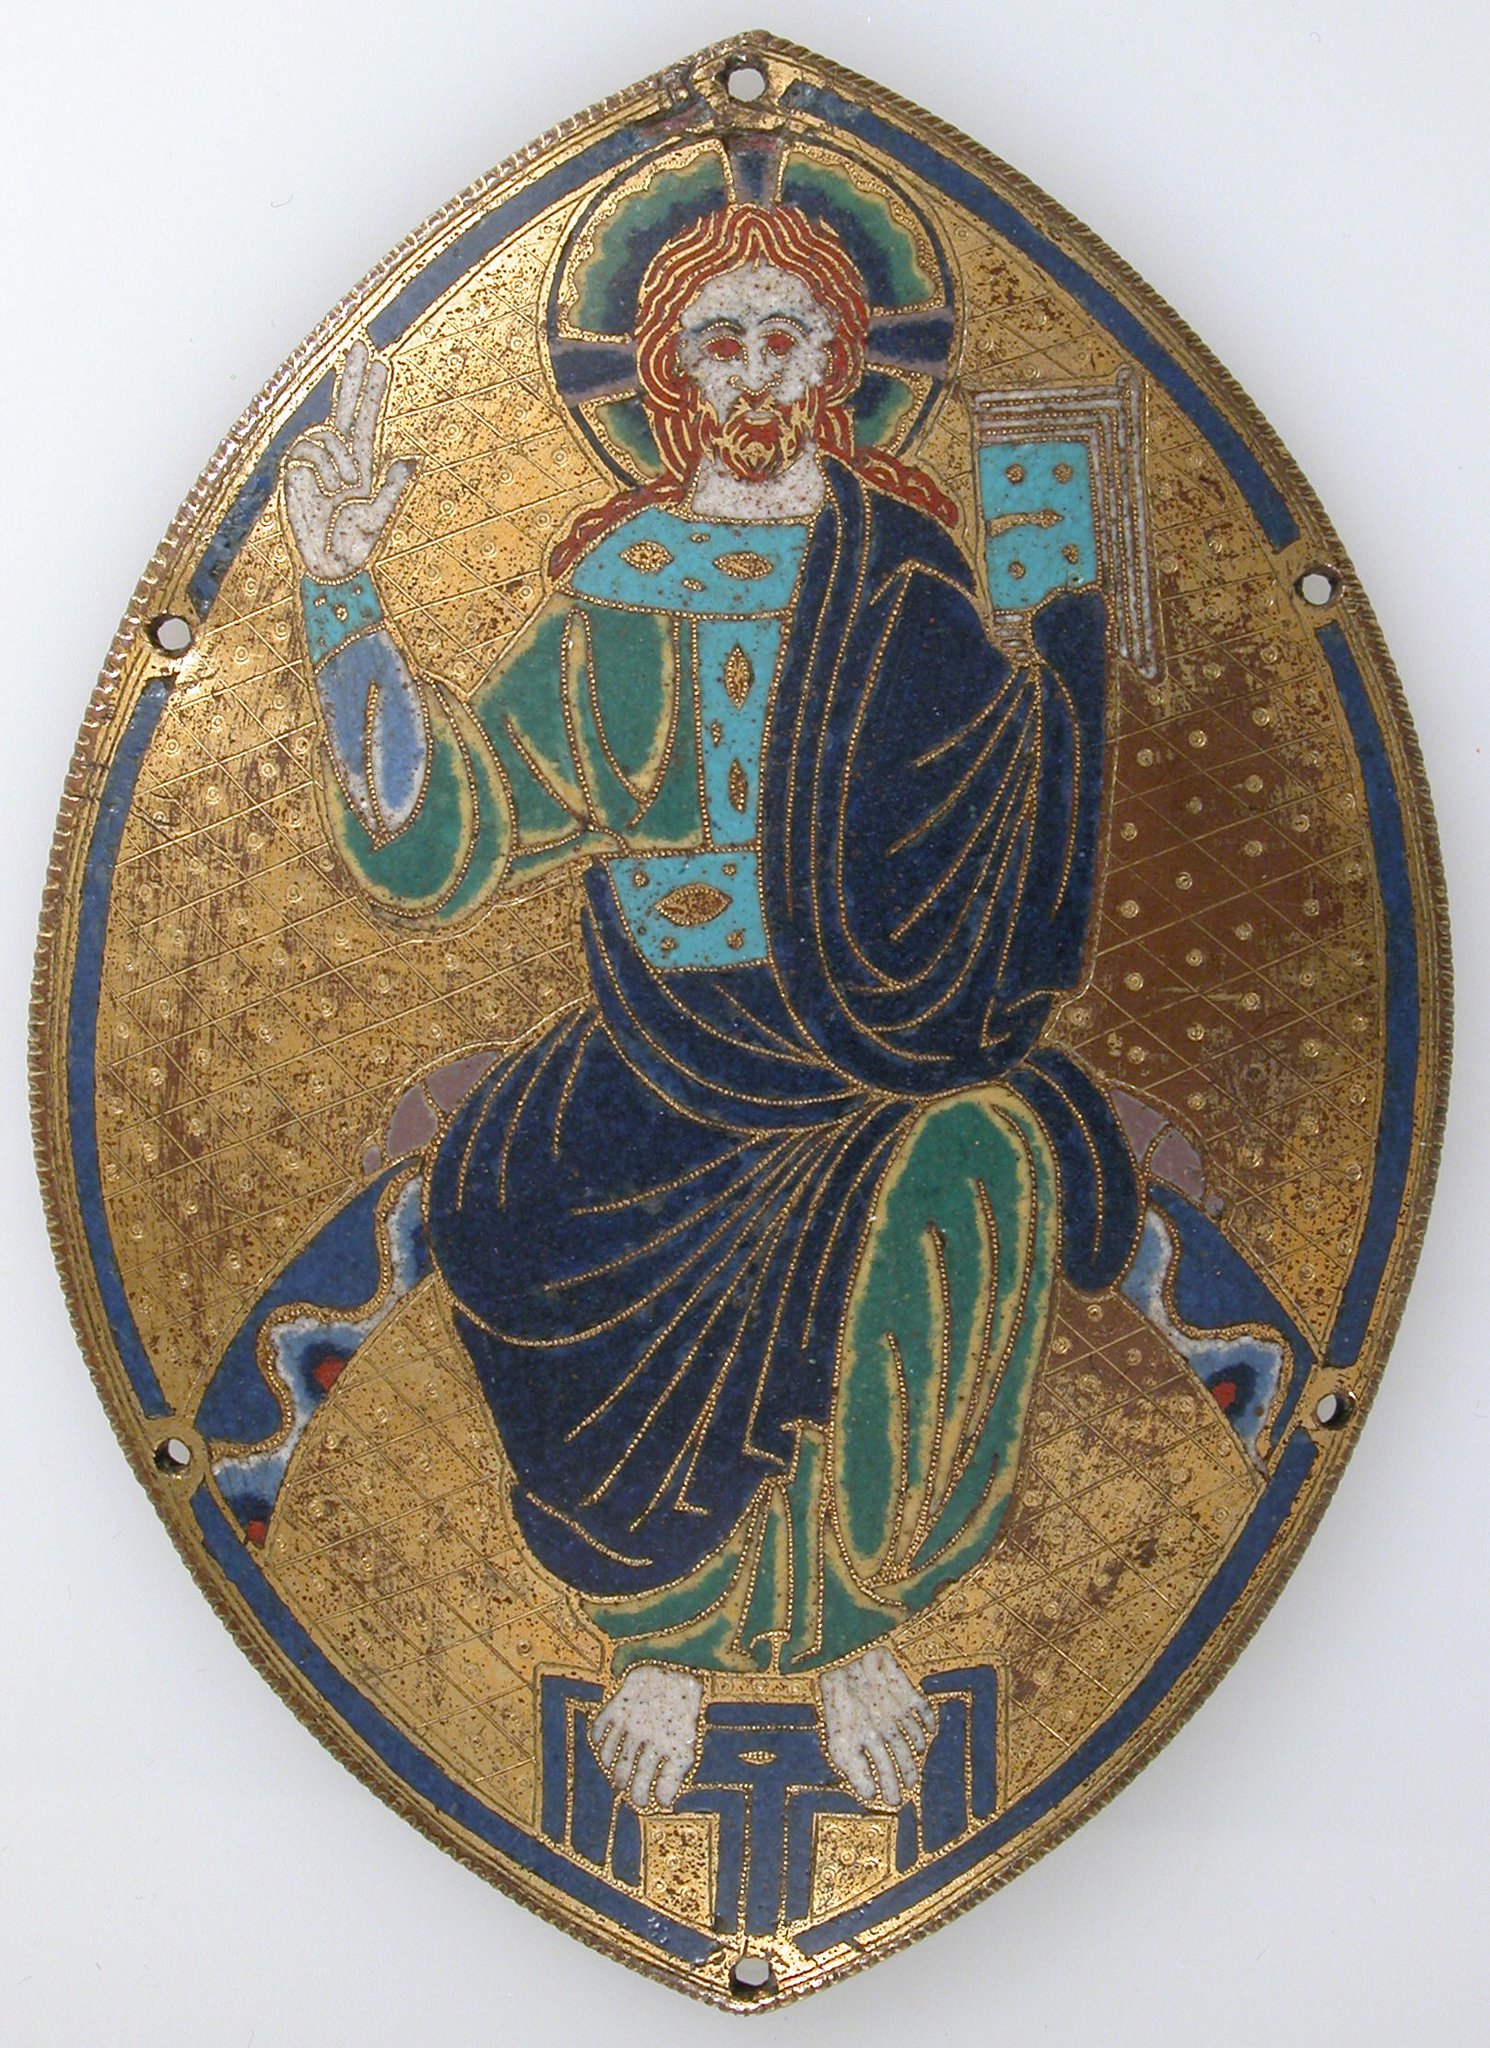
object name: plaque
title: Plaque with Christ Blessing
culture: french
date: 1190-1200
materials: copper, enamel, gilt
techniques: enamel, engraving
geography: france